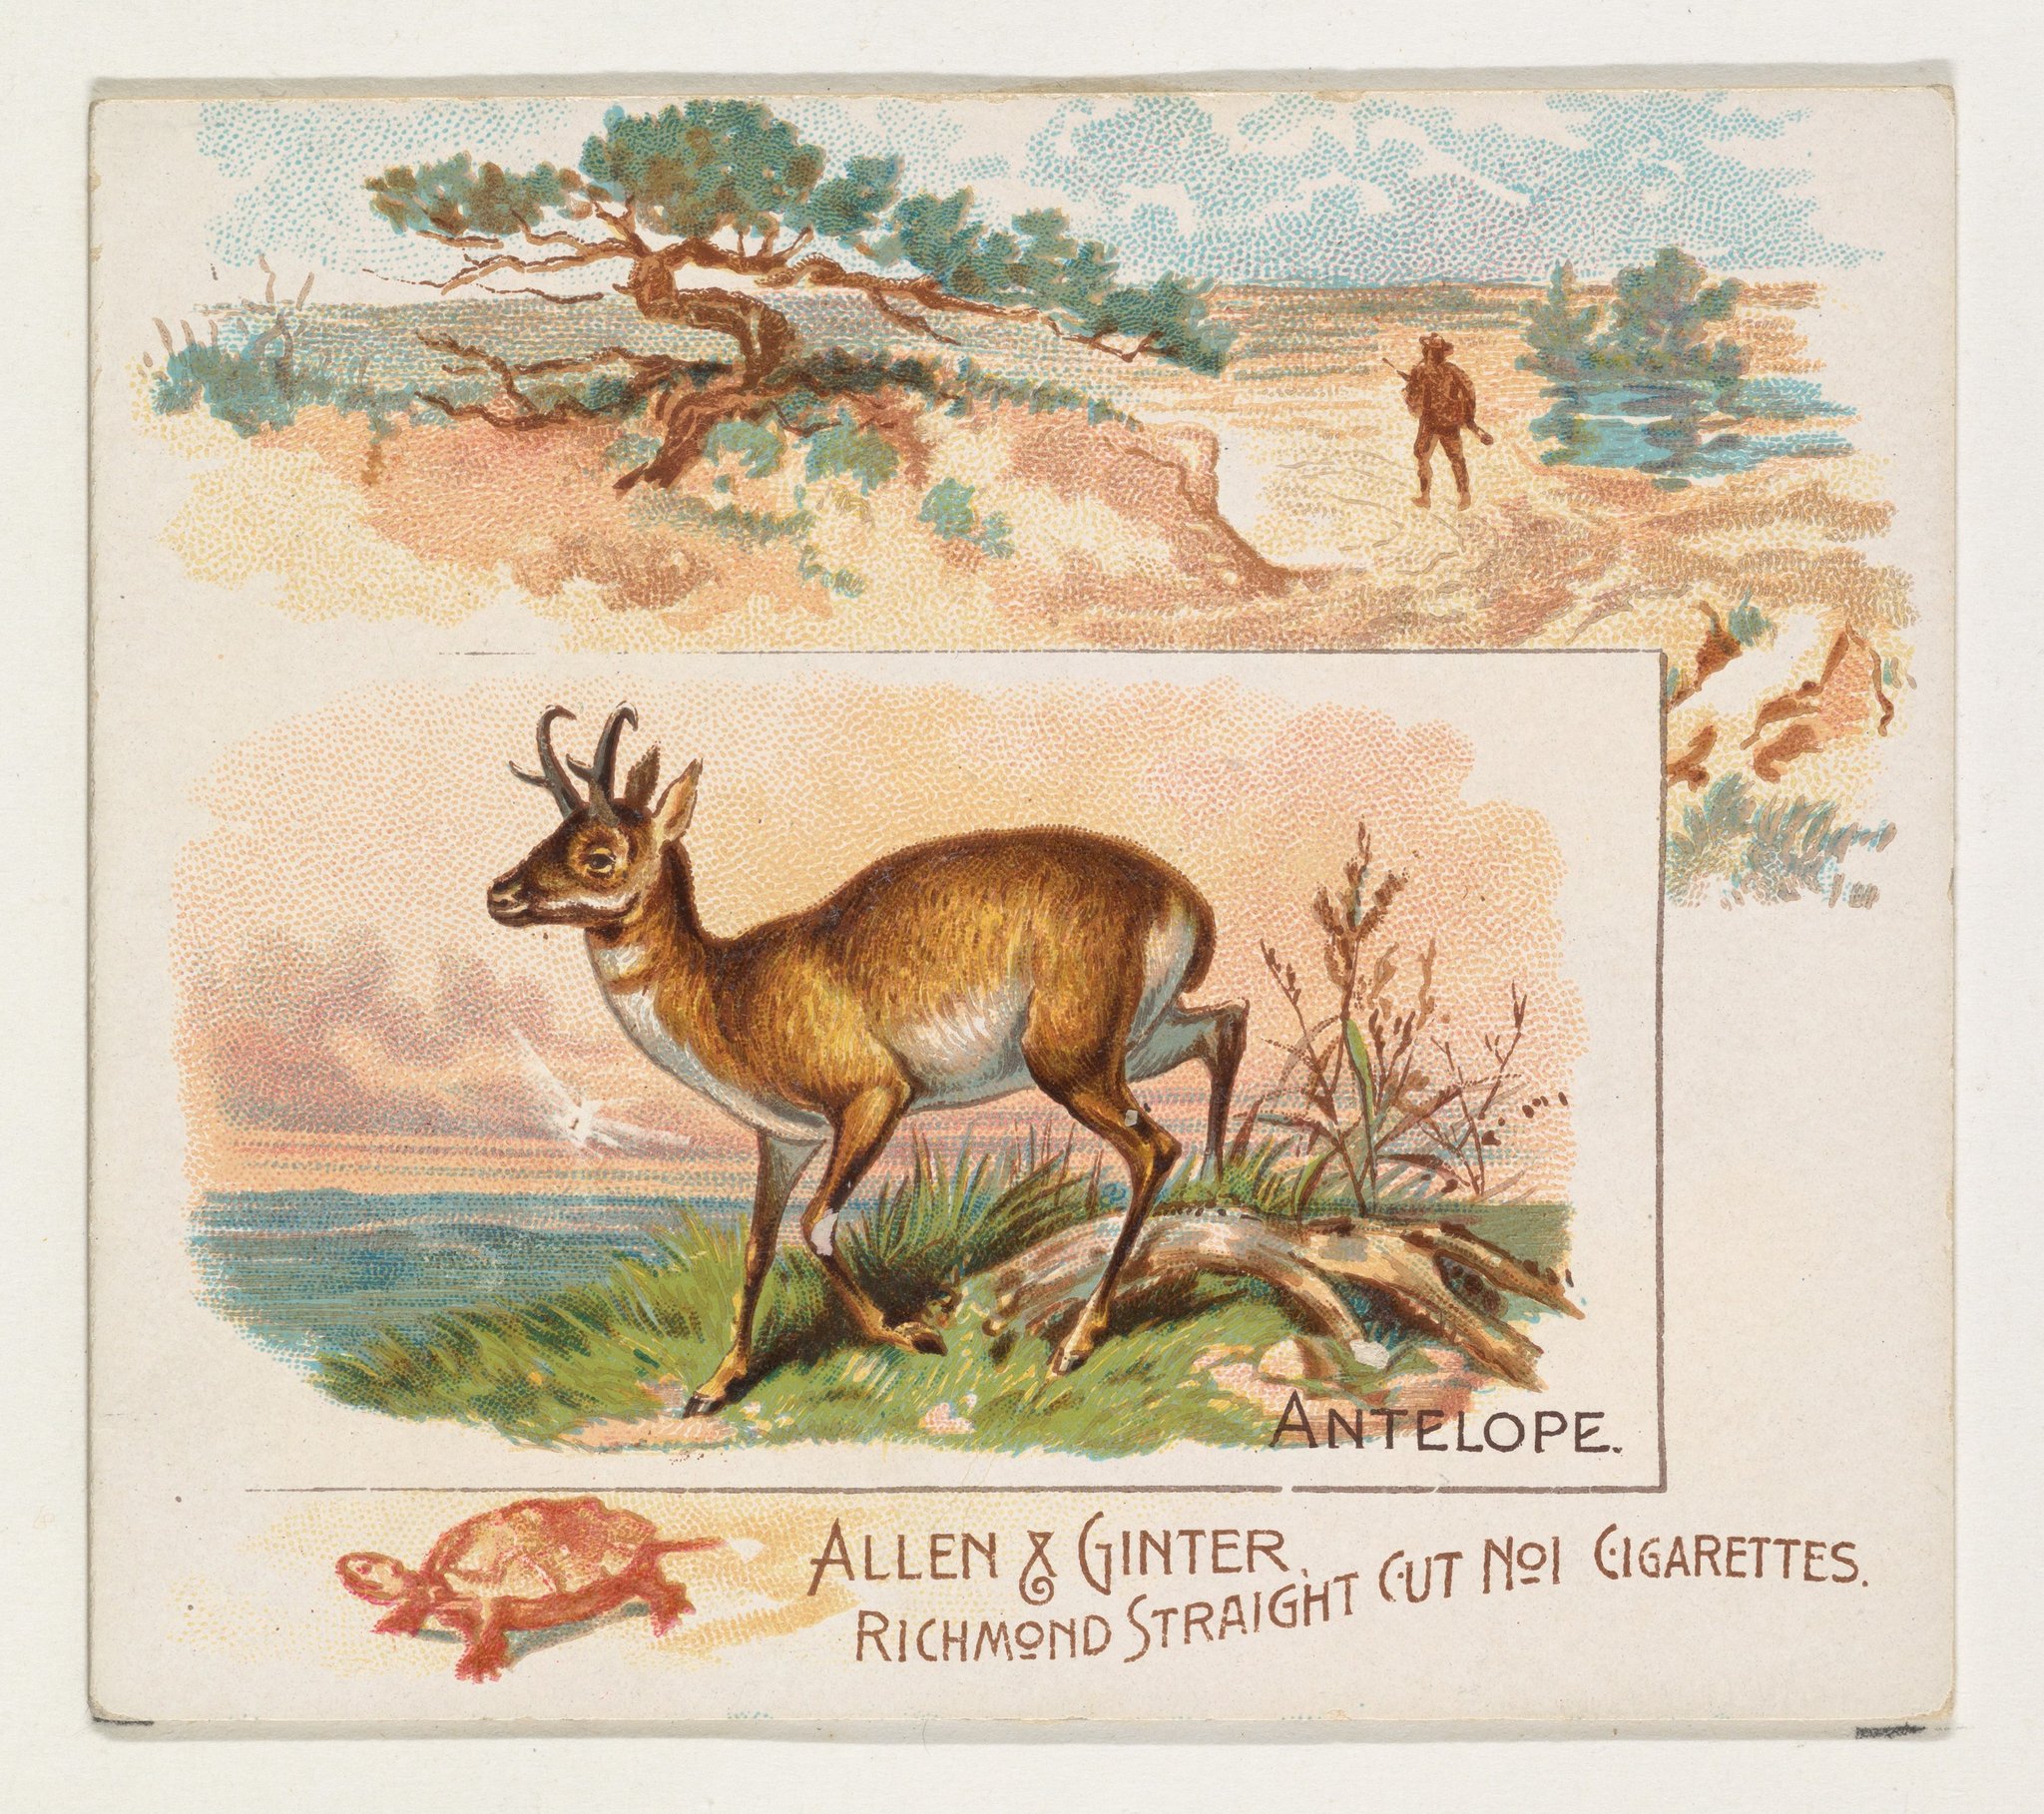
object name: print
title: Antelope, from Quadrupeds series (N41) for Allen & Ginter Cigarettes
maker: allen & ginter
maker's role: publisher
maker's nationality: american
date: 1890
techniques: color lithograph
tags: antelope